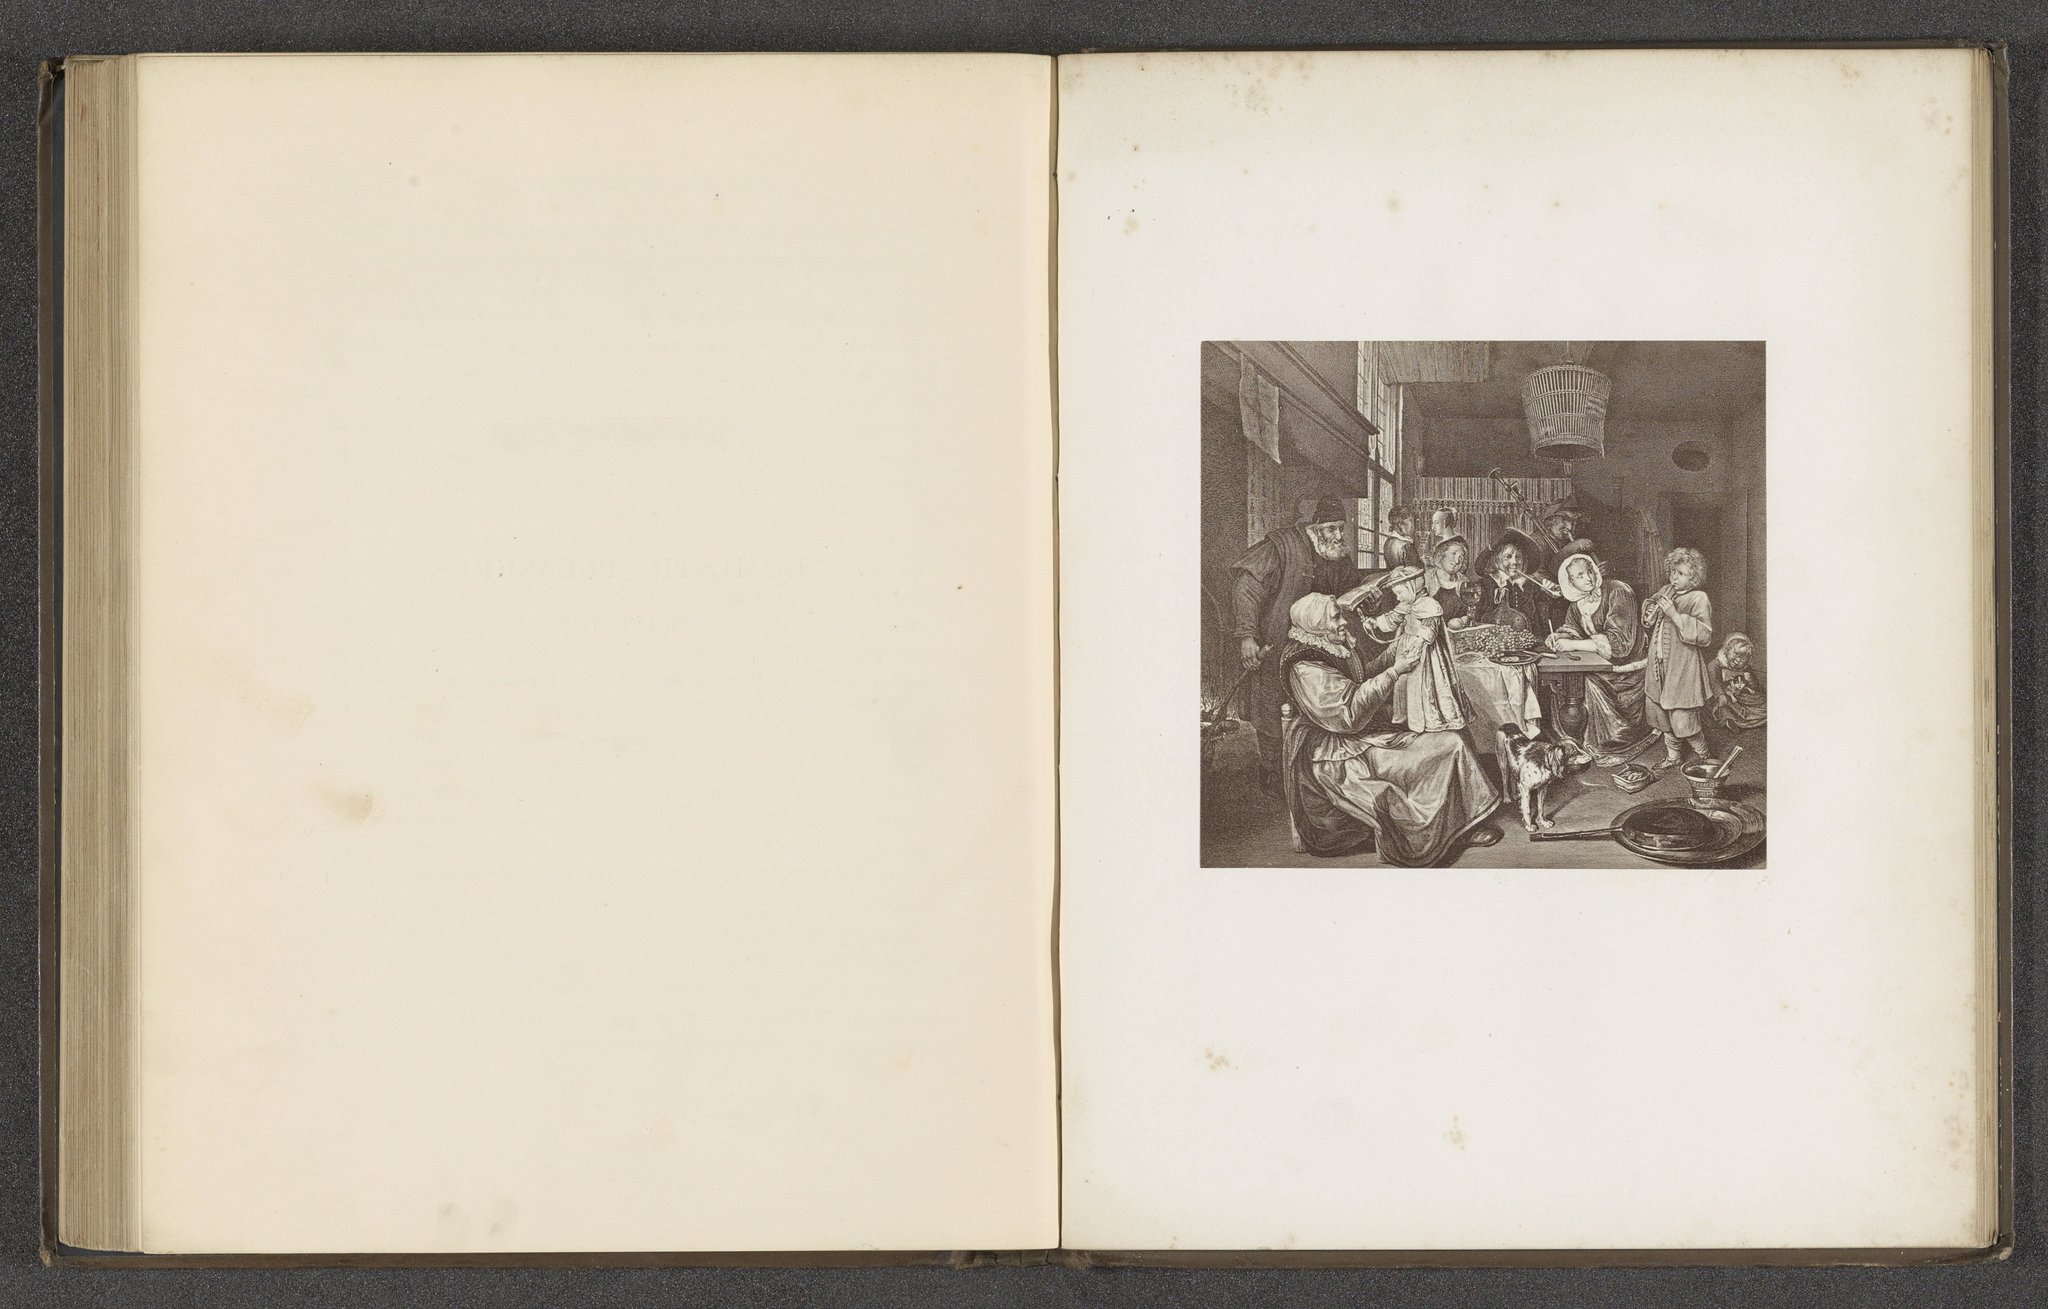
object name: page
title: Fotoreproductie van een prent naar een schilderij, voorstellende een interieur met een familie aan tafel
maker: Anonymous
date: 1859-1869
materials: paper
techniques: woodburytype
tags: one person playing string instrument (bowed), interior ~ representation of a building